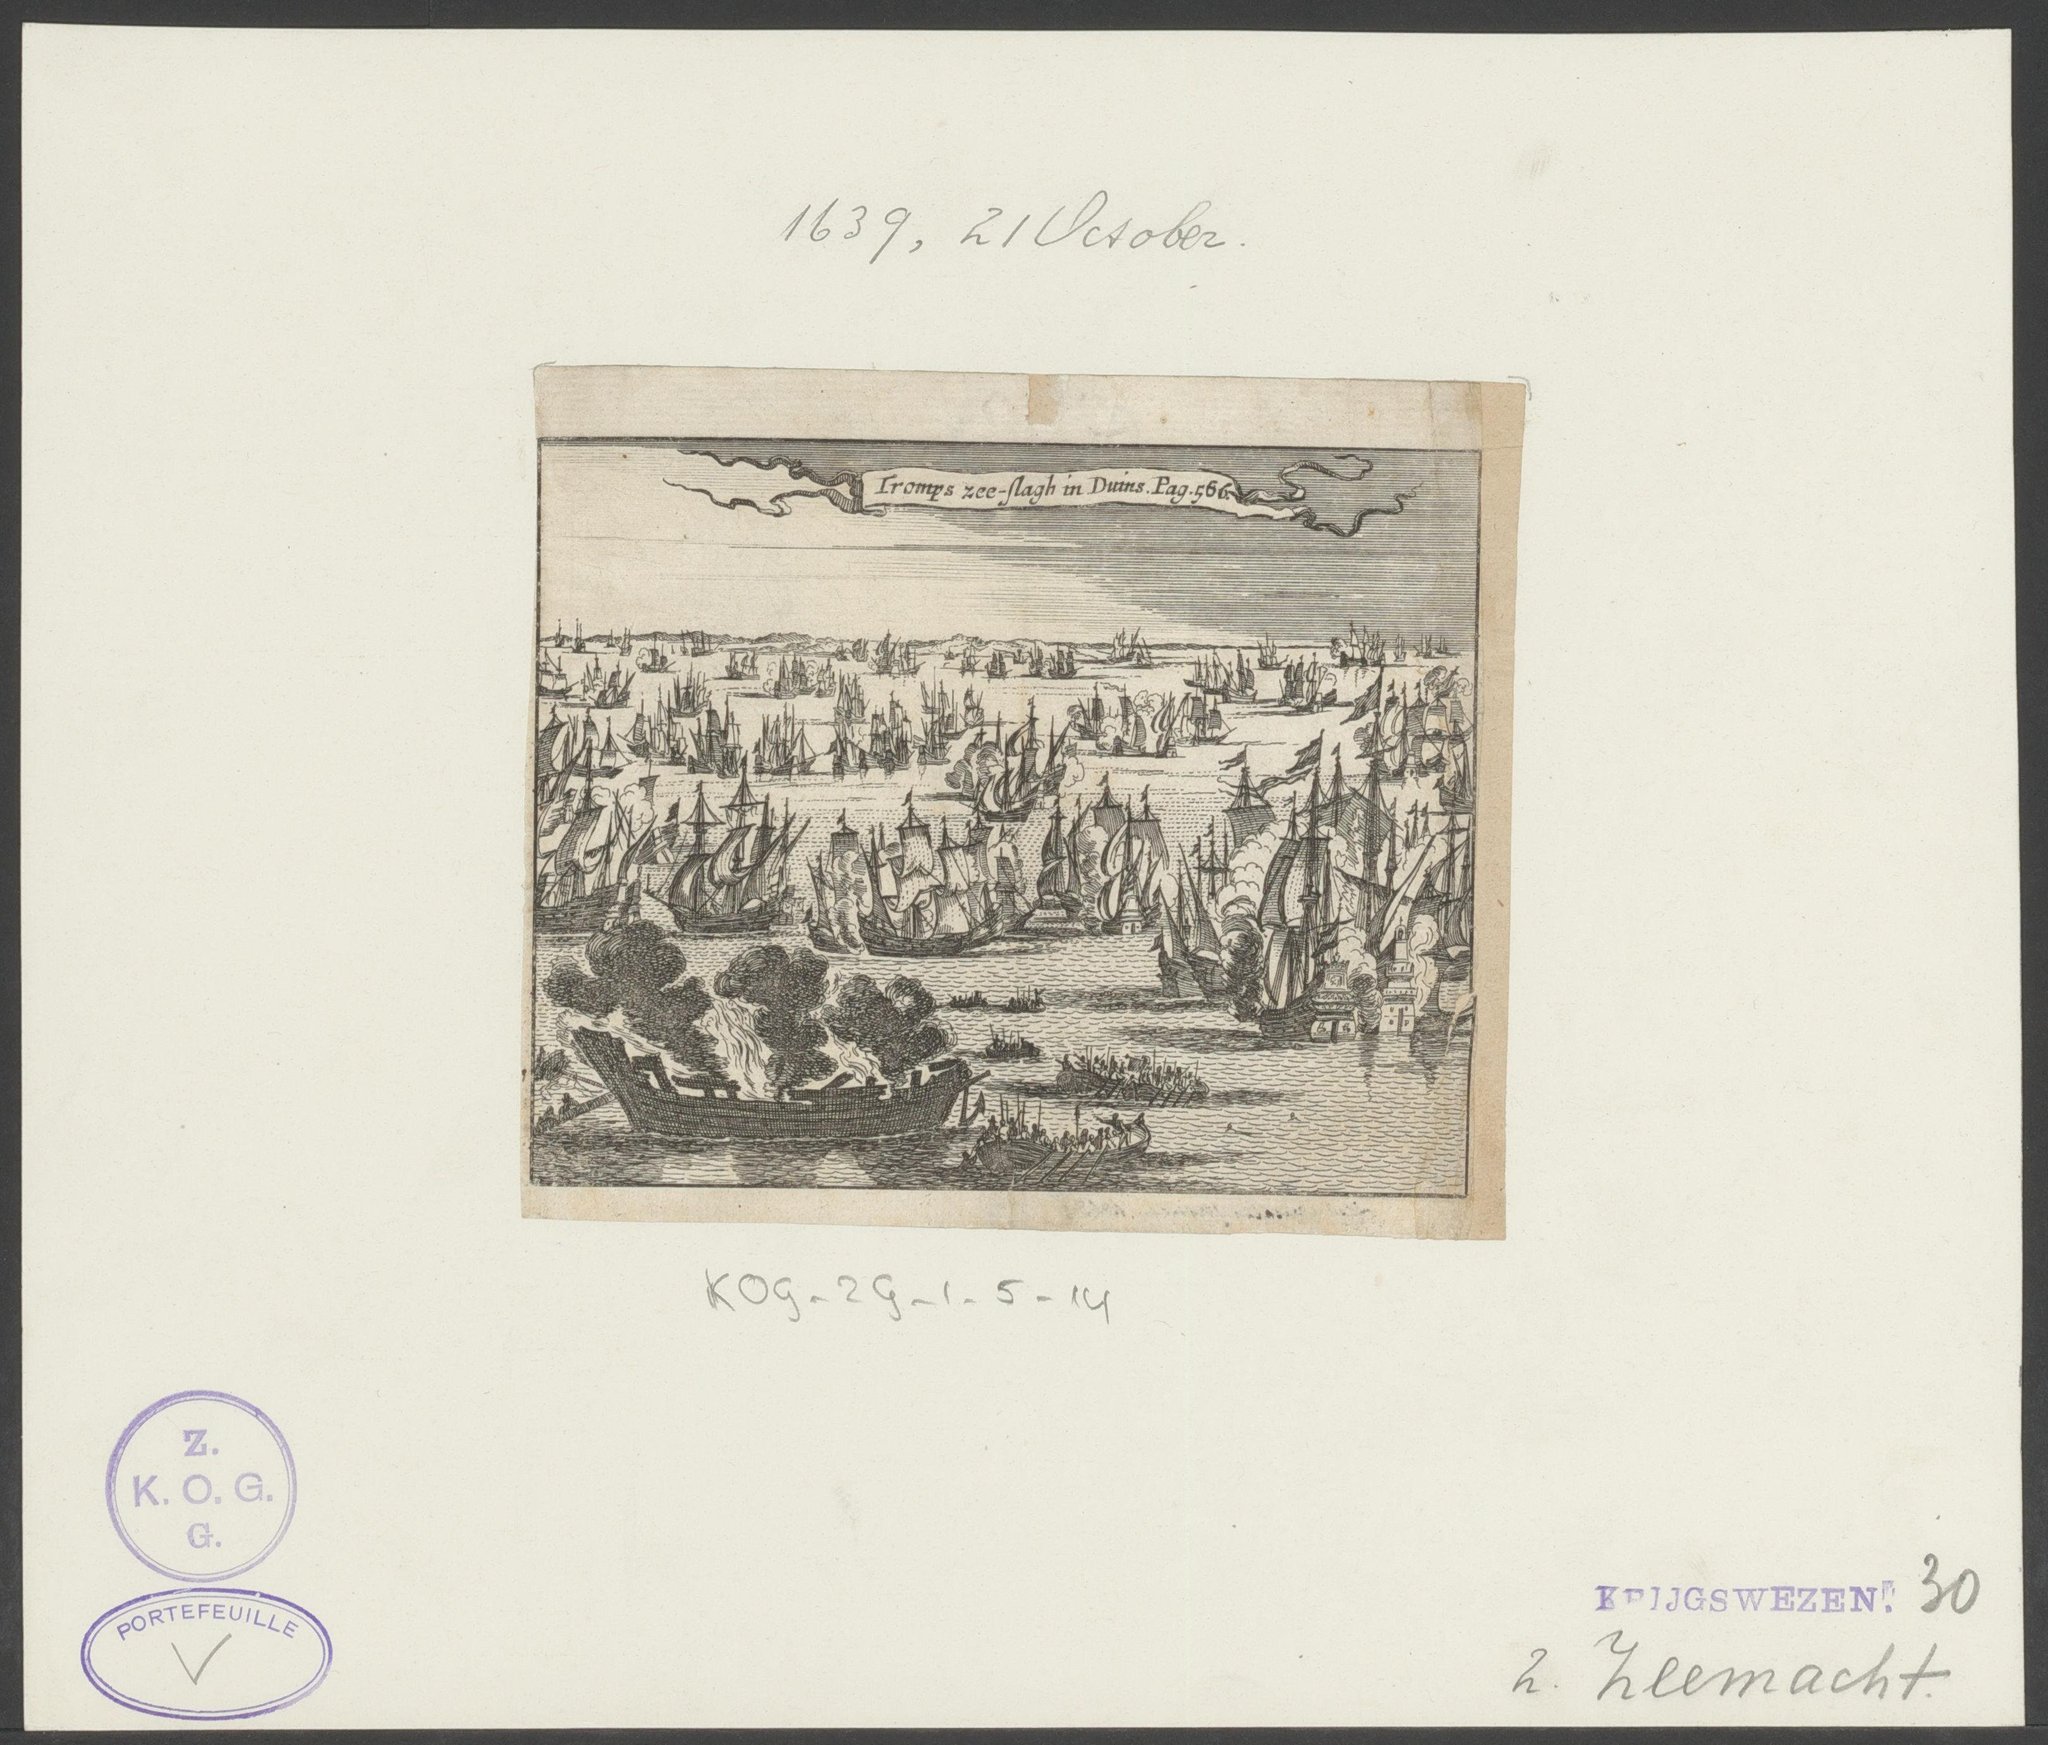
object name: print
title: Zeeslag bij Duins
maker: Anonymous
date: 1650-1699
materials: paper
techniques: engraving, etching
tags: sailing-ship, sailing-boat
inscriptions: stamp, collector's mark: Lugt 1641, stamp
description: Zeeslag bij Duins tussen de Spaanse vloot onder bevel van Antonio de Oquendo en de Staatse vloot onder Maarten Harpertsz. Tromp, 21 oktober 1639. Rechts op de spiegel gezien het admiraalsschip van Tromp de Aemilia (Amelia) naast de Santa Teresa die in brand staat. Links op de voorgrond een brandend schip en sloepen met bemanningsleden. Op de achtergrond de Engelse kust. Bovenaan in het midden een de titel en het nummer: Pag. 566. Onderwerpsrubrieken binnen de Atlas Zeden en Gewoonten: Krijgswezen, Zeemacht.